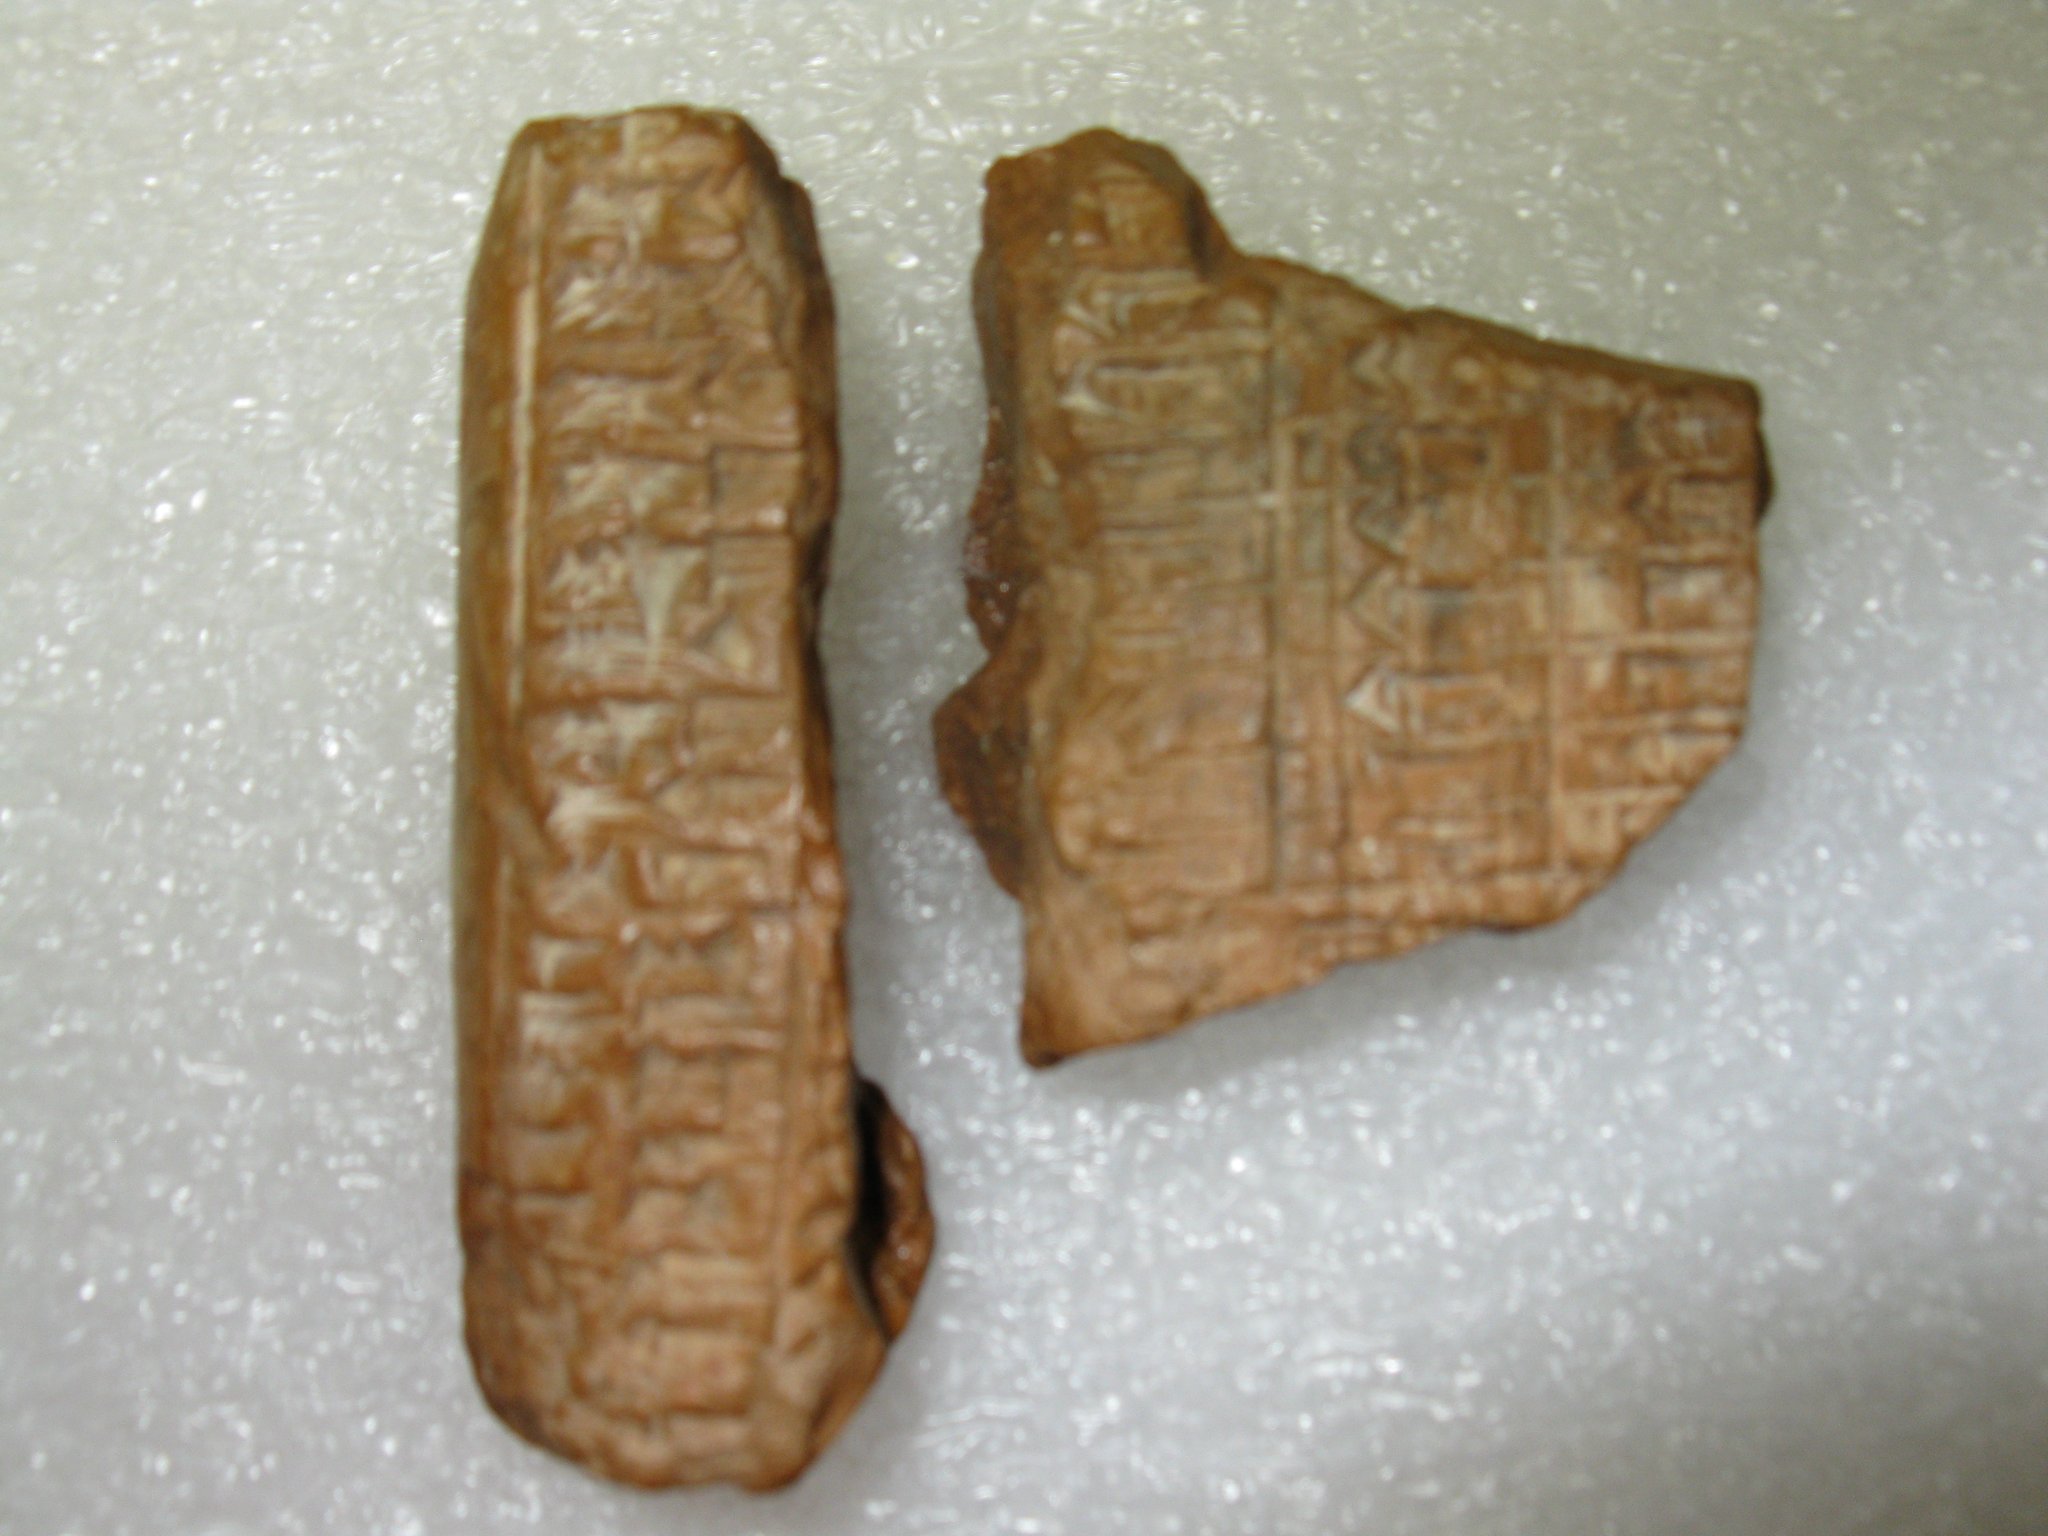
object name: cuneiform tablet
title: Cuneiform tablet: fragment of an astronomical table (?)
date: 333-1 BCE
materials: clay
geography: mesopotamia